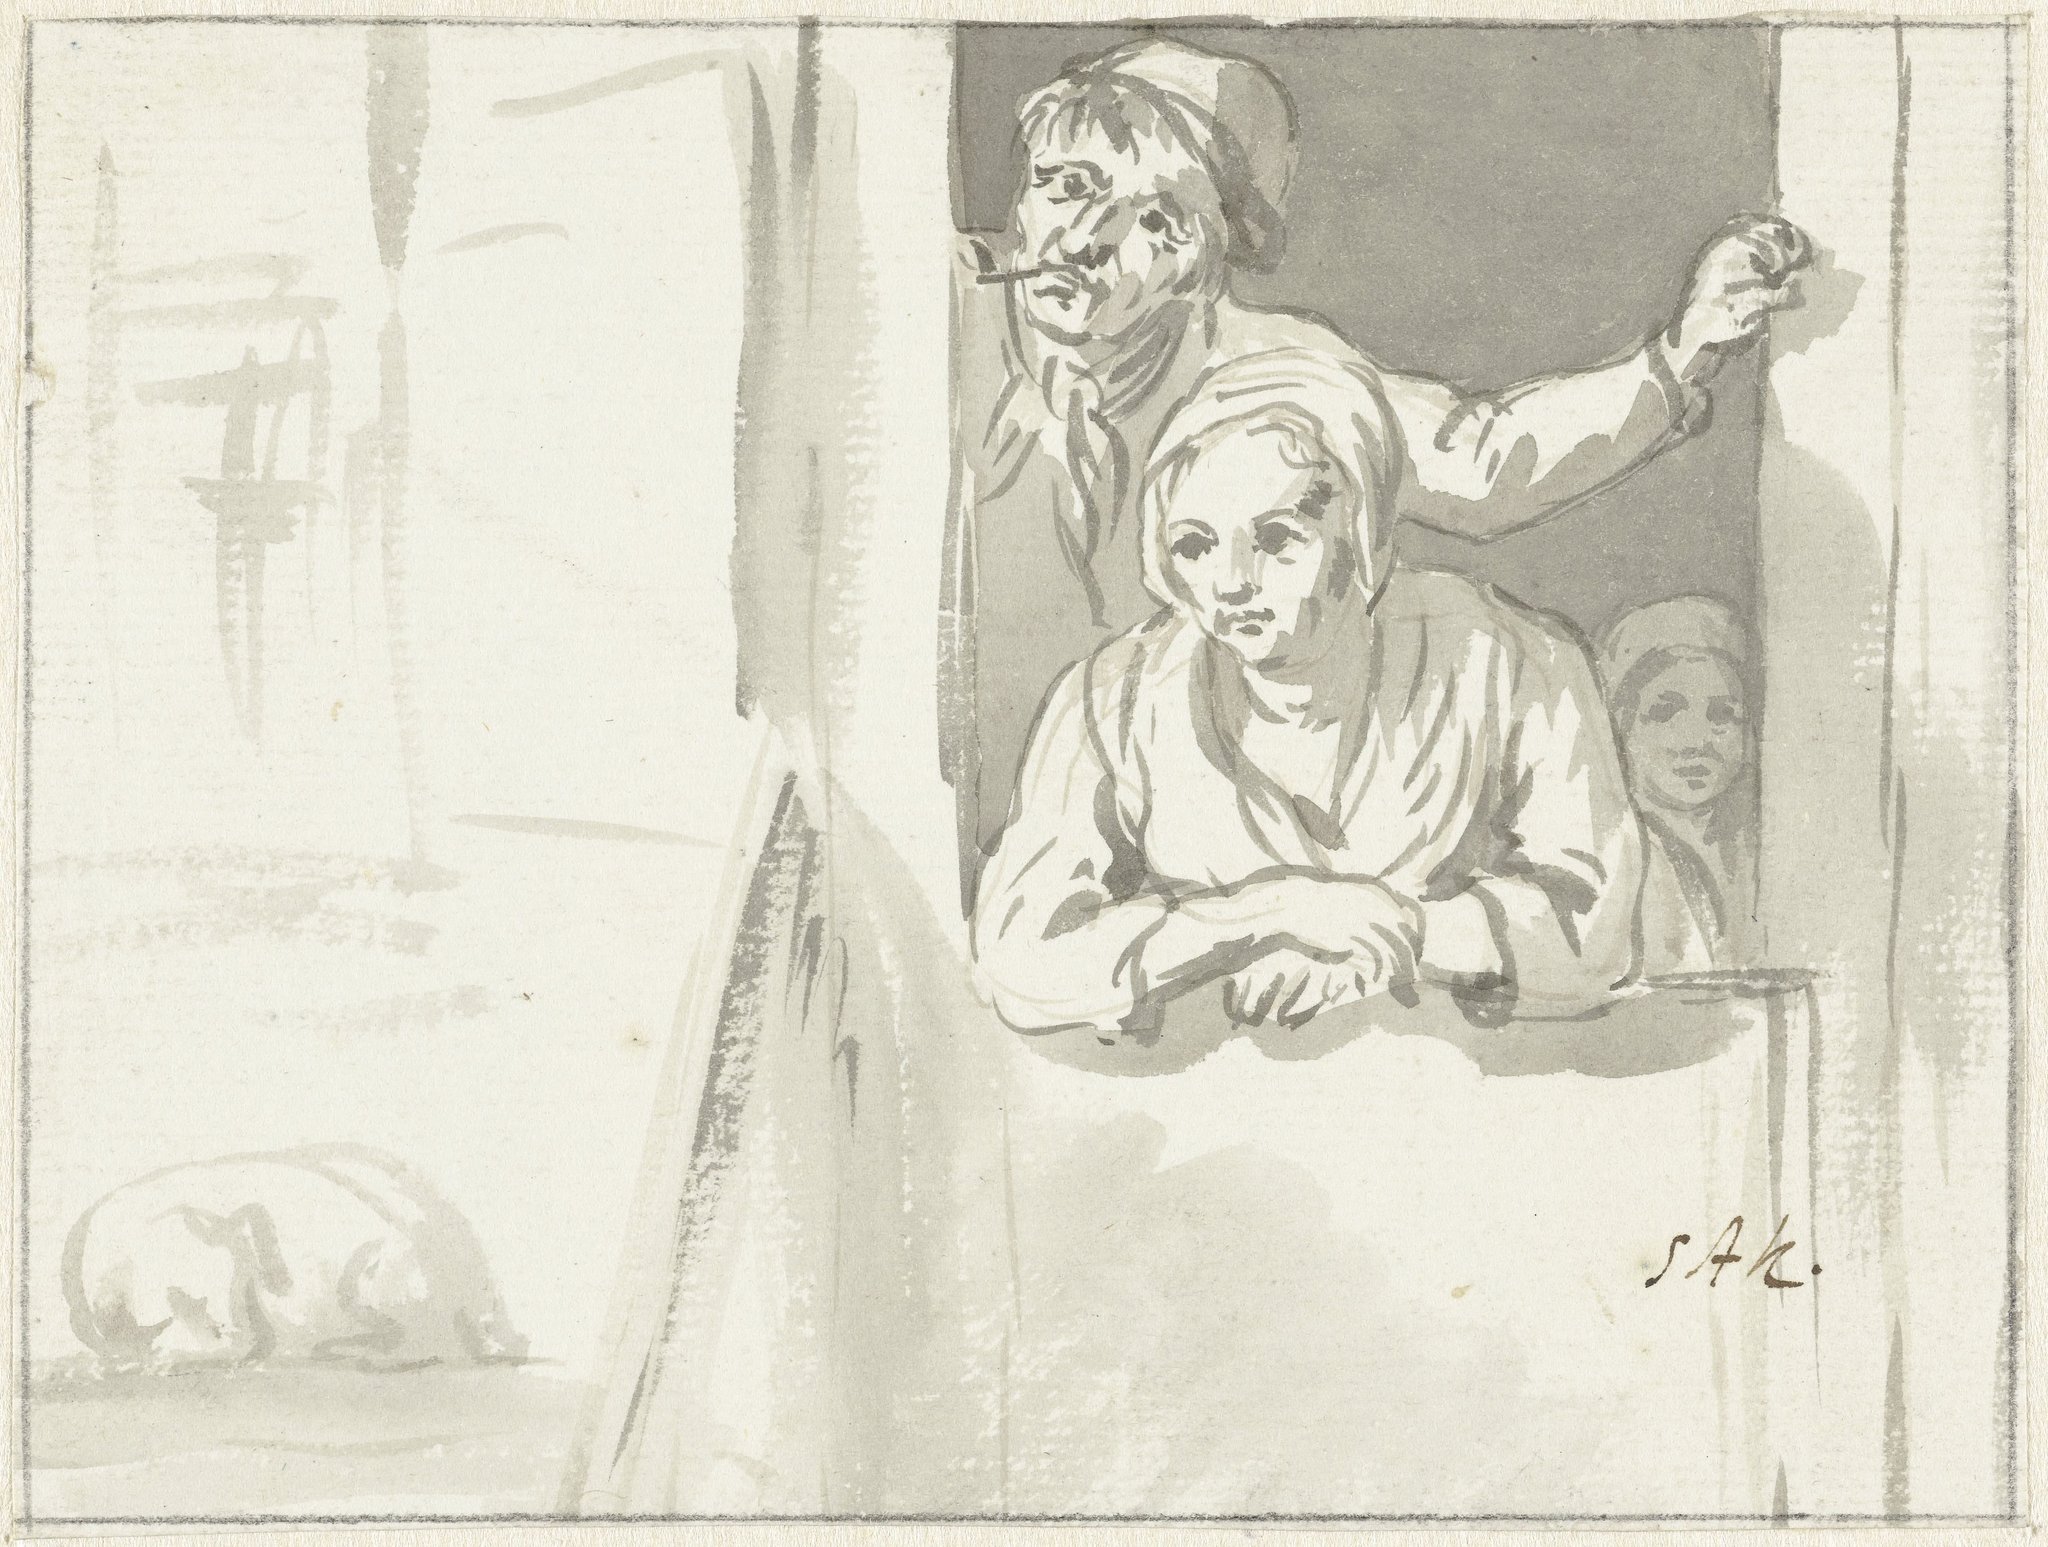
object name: drawing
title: Familie over een onderdeur naar buiten ziend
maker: simon andreas krausz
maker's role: draughtsman, print maker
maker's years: 1760-1825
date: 1770-1825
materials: paper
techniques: brush